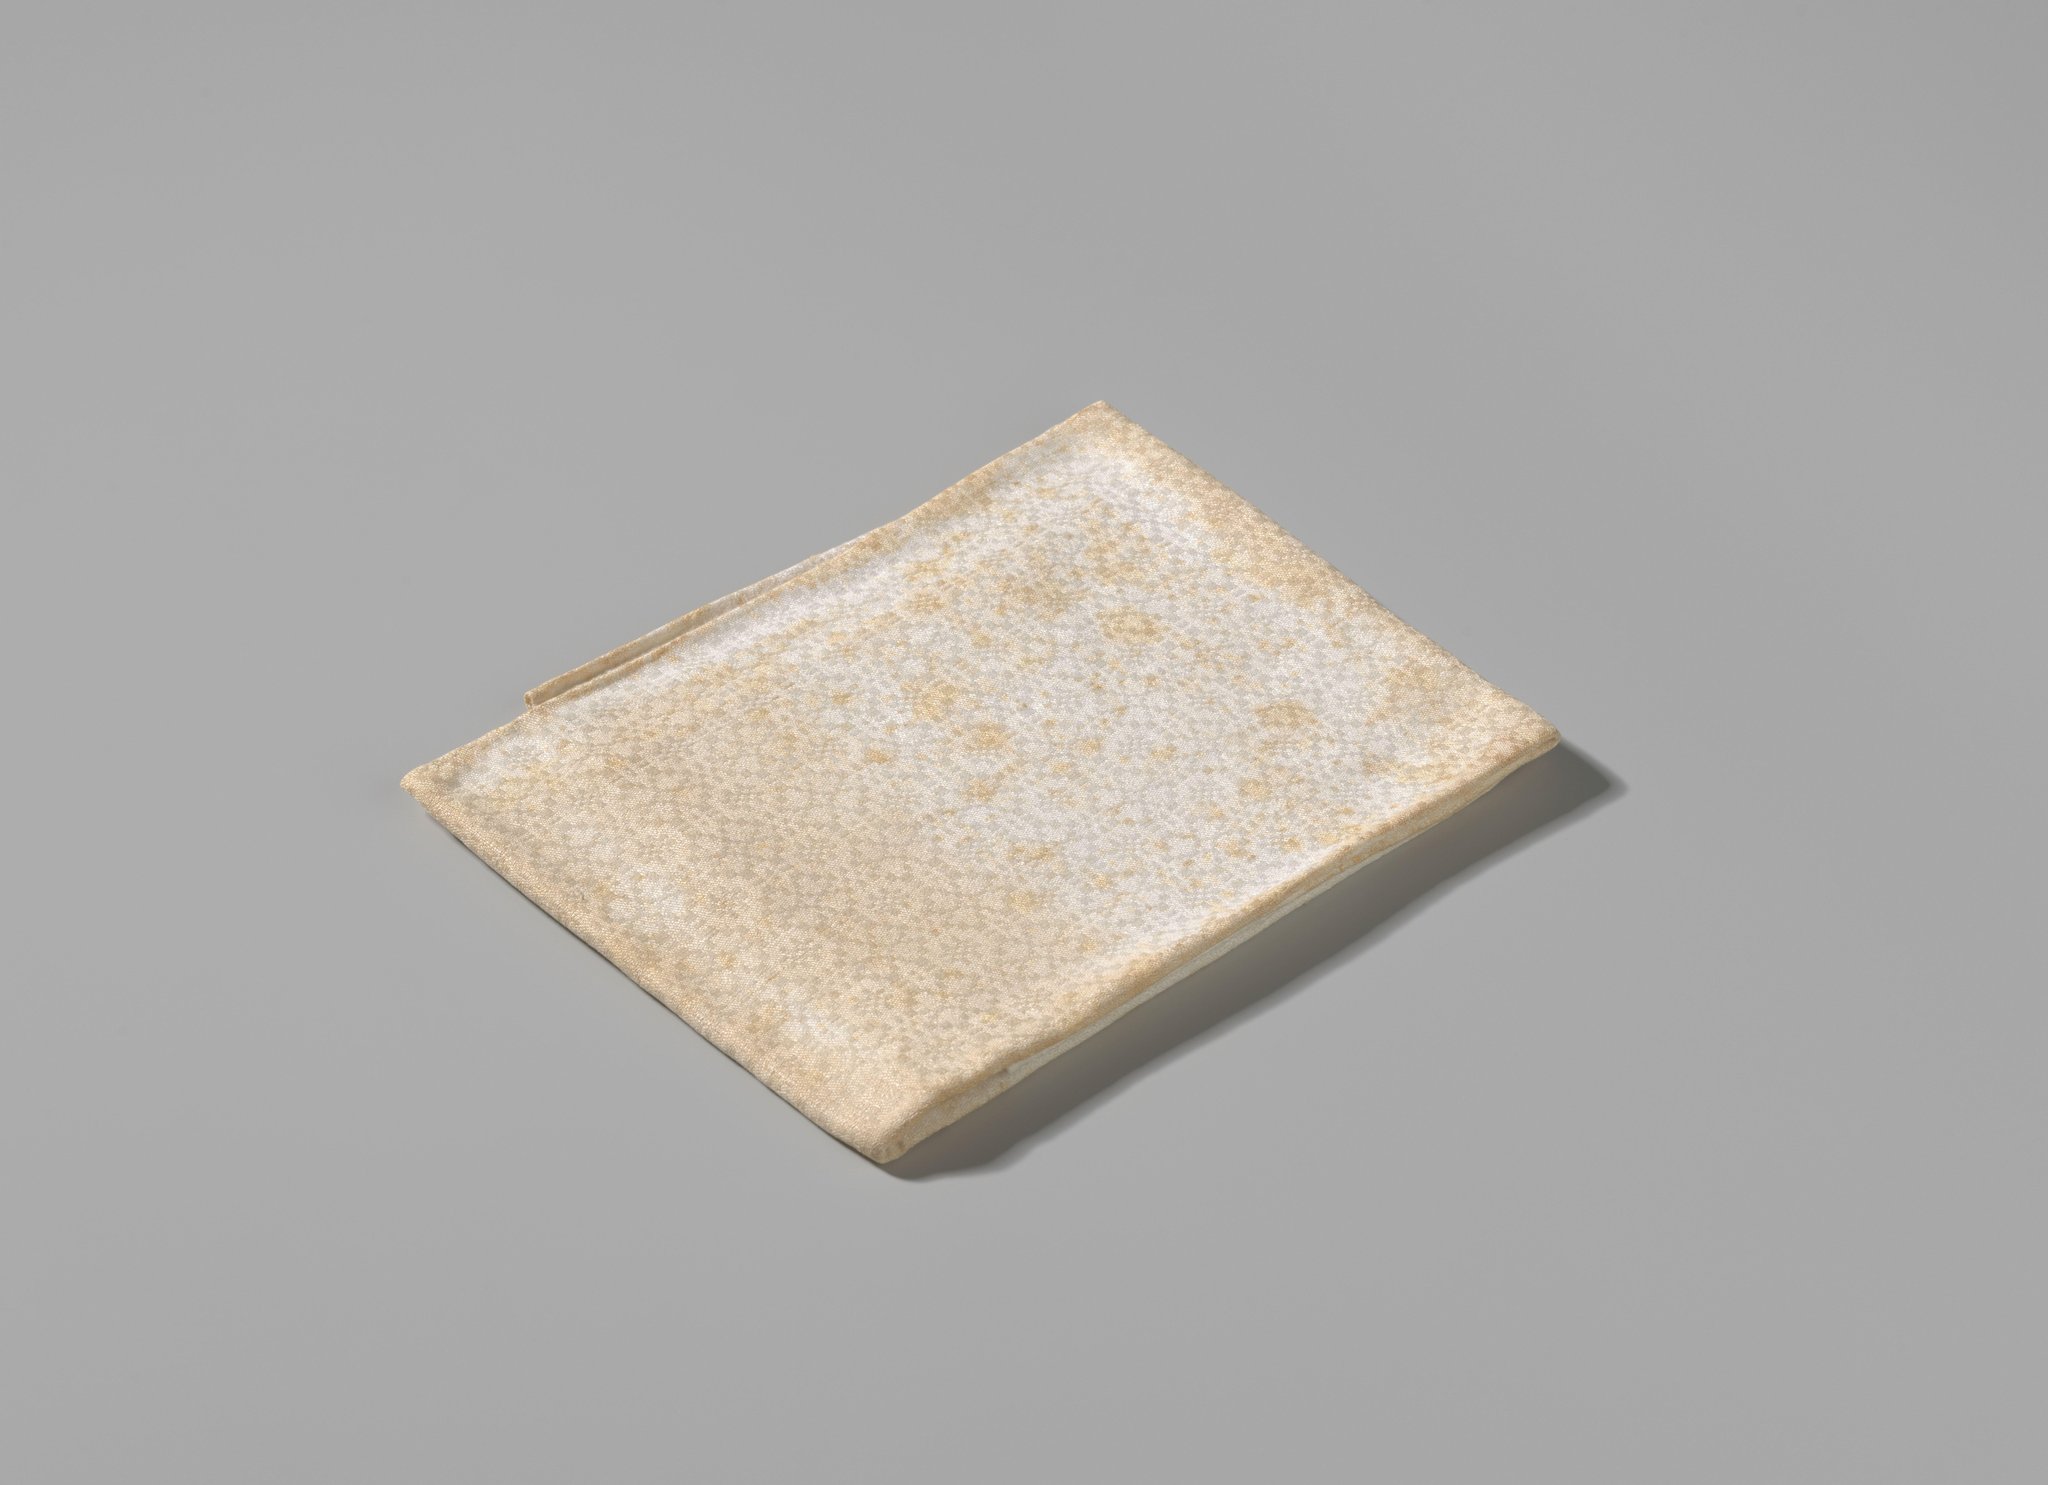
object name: napkin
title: Servet van pellendamast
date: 1600-1699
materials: linen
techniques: weave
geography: netherlands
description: Servet van pellendamast. Bij het servet hoort een servet met invnr. BK-1980-109-A.